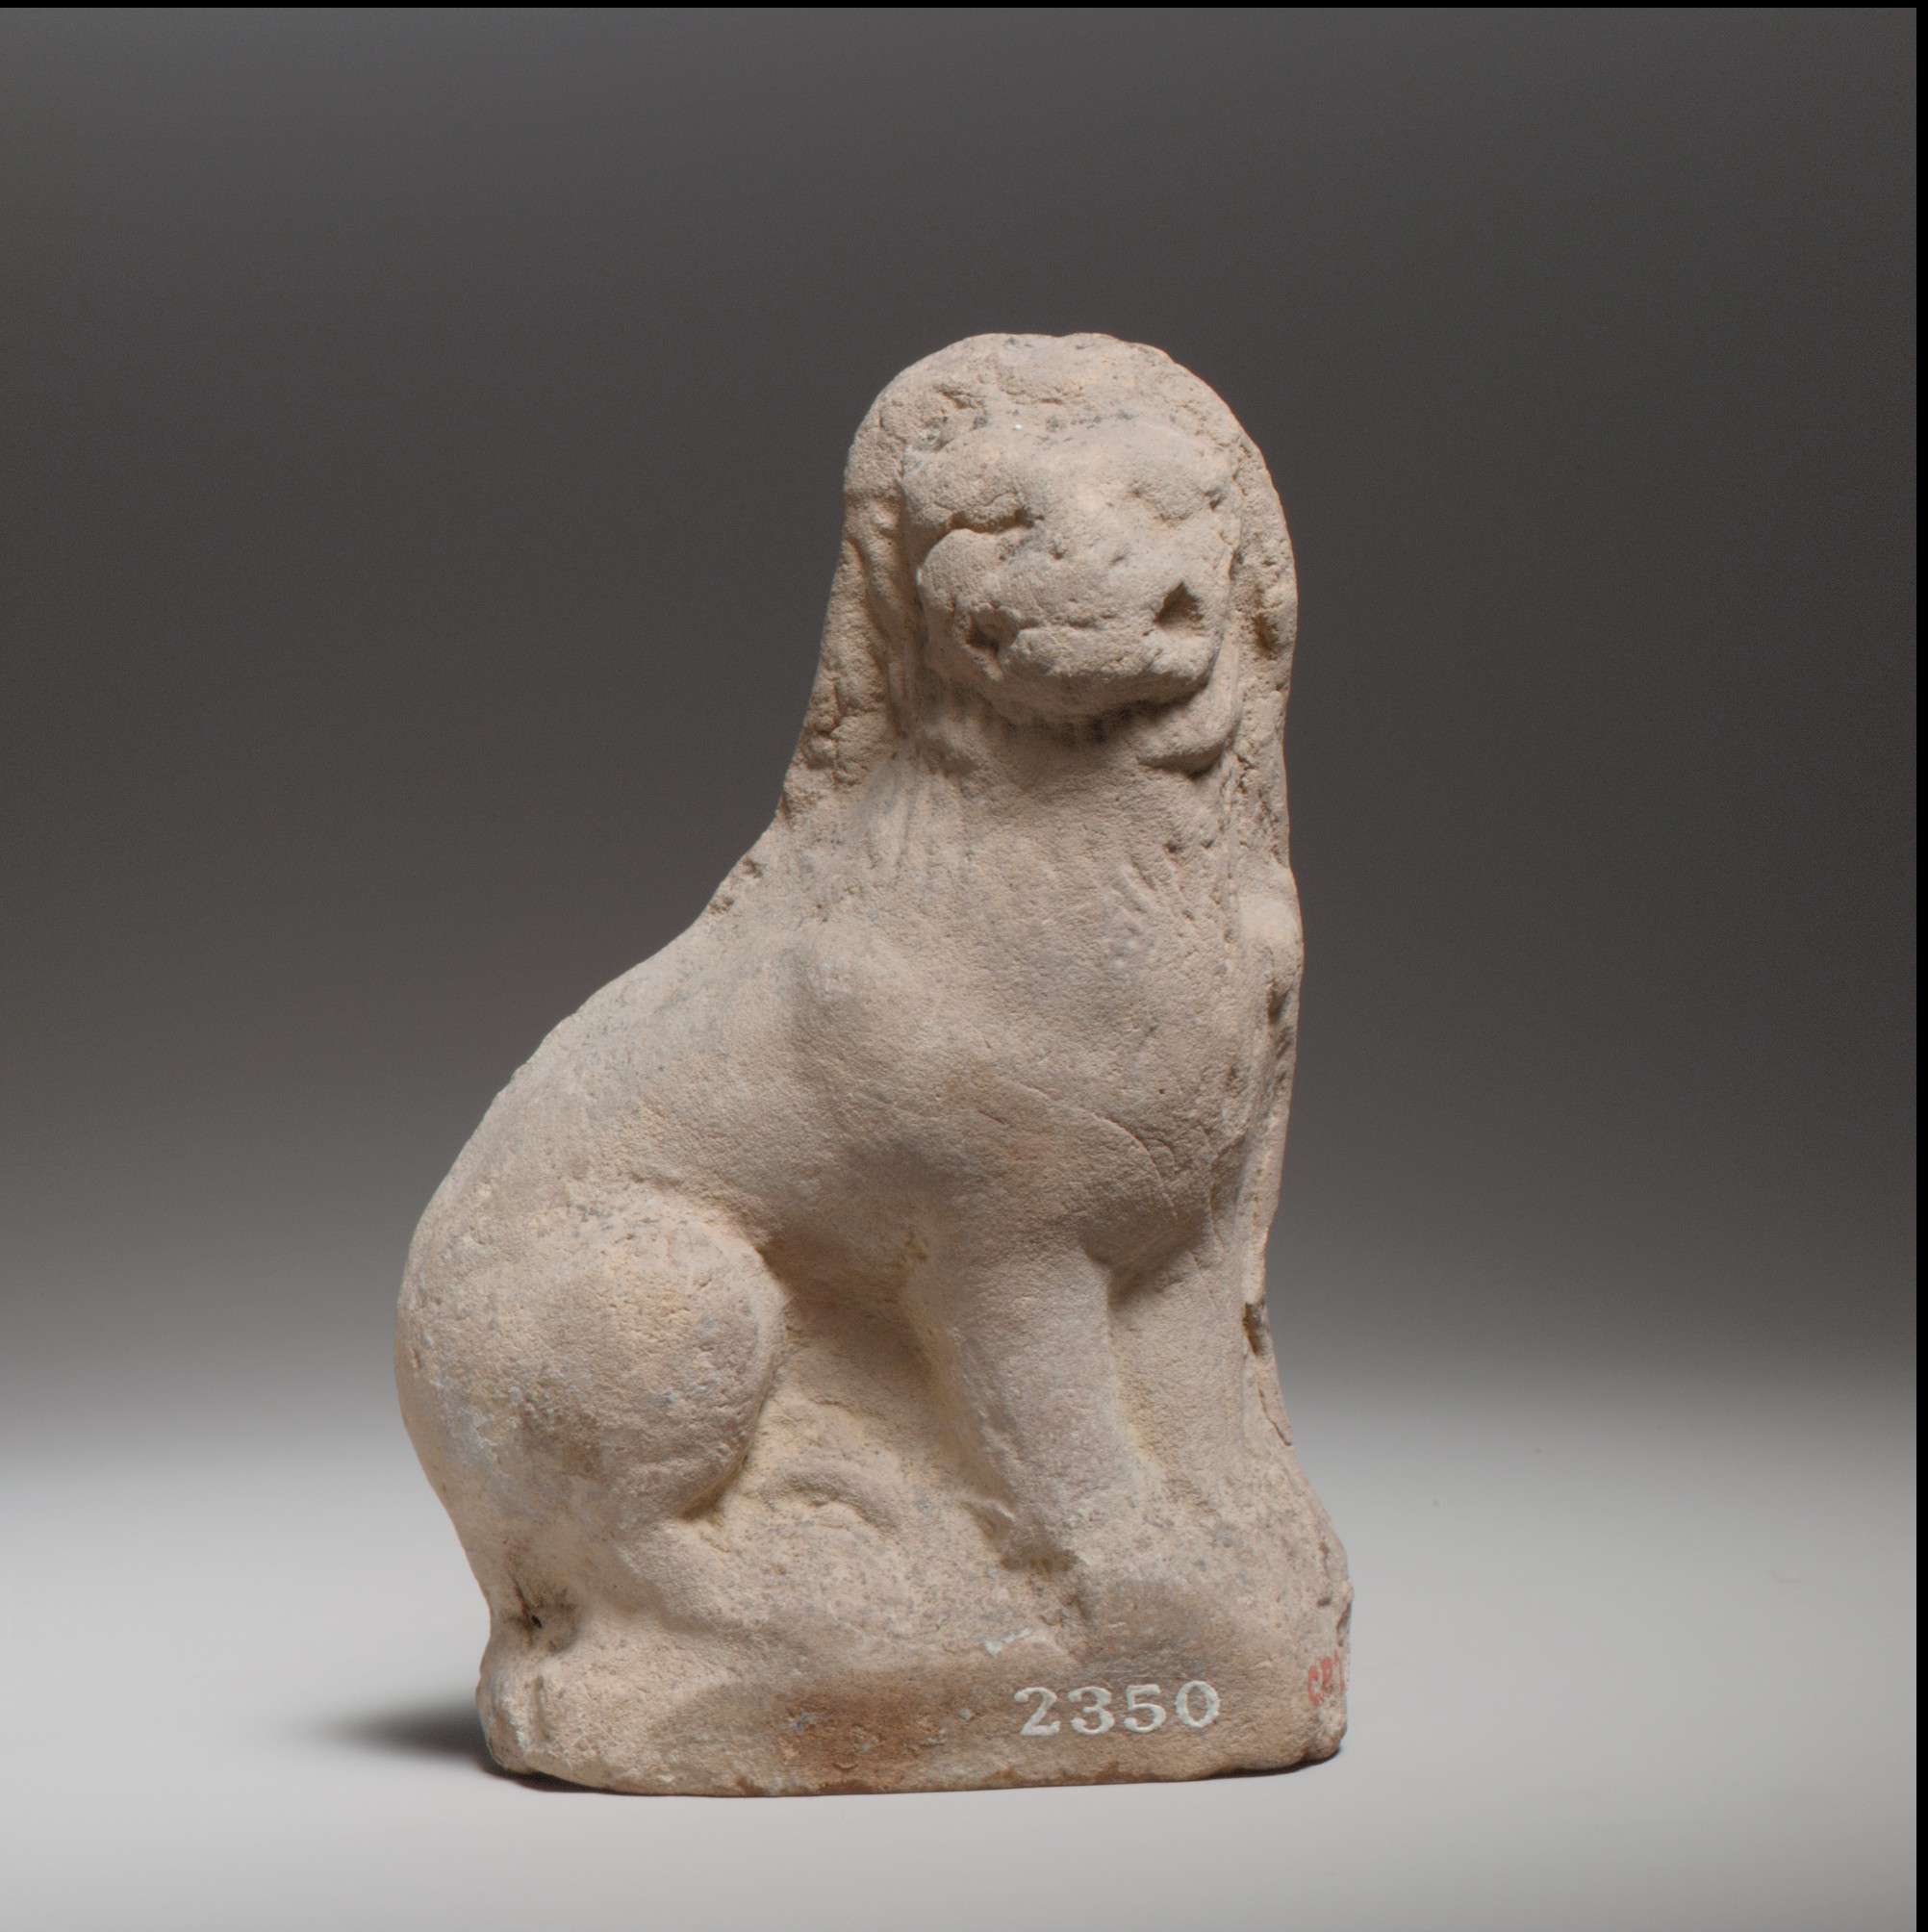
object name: statuette of a lion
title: Lion figurine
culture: cypriot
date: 100 BCE-100 CE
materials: terracotta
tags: lions